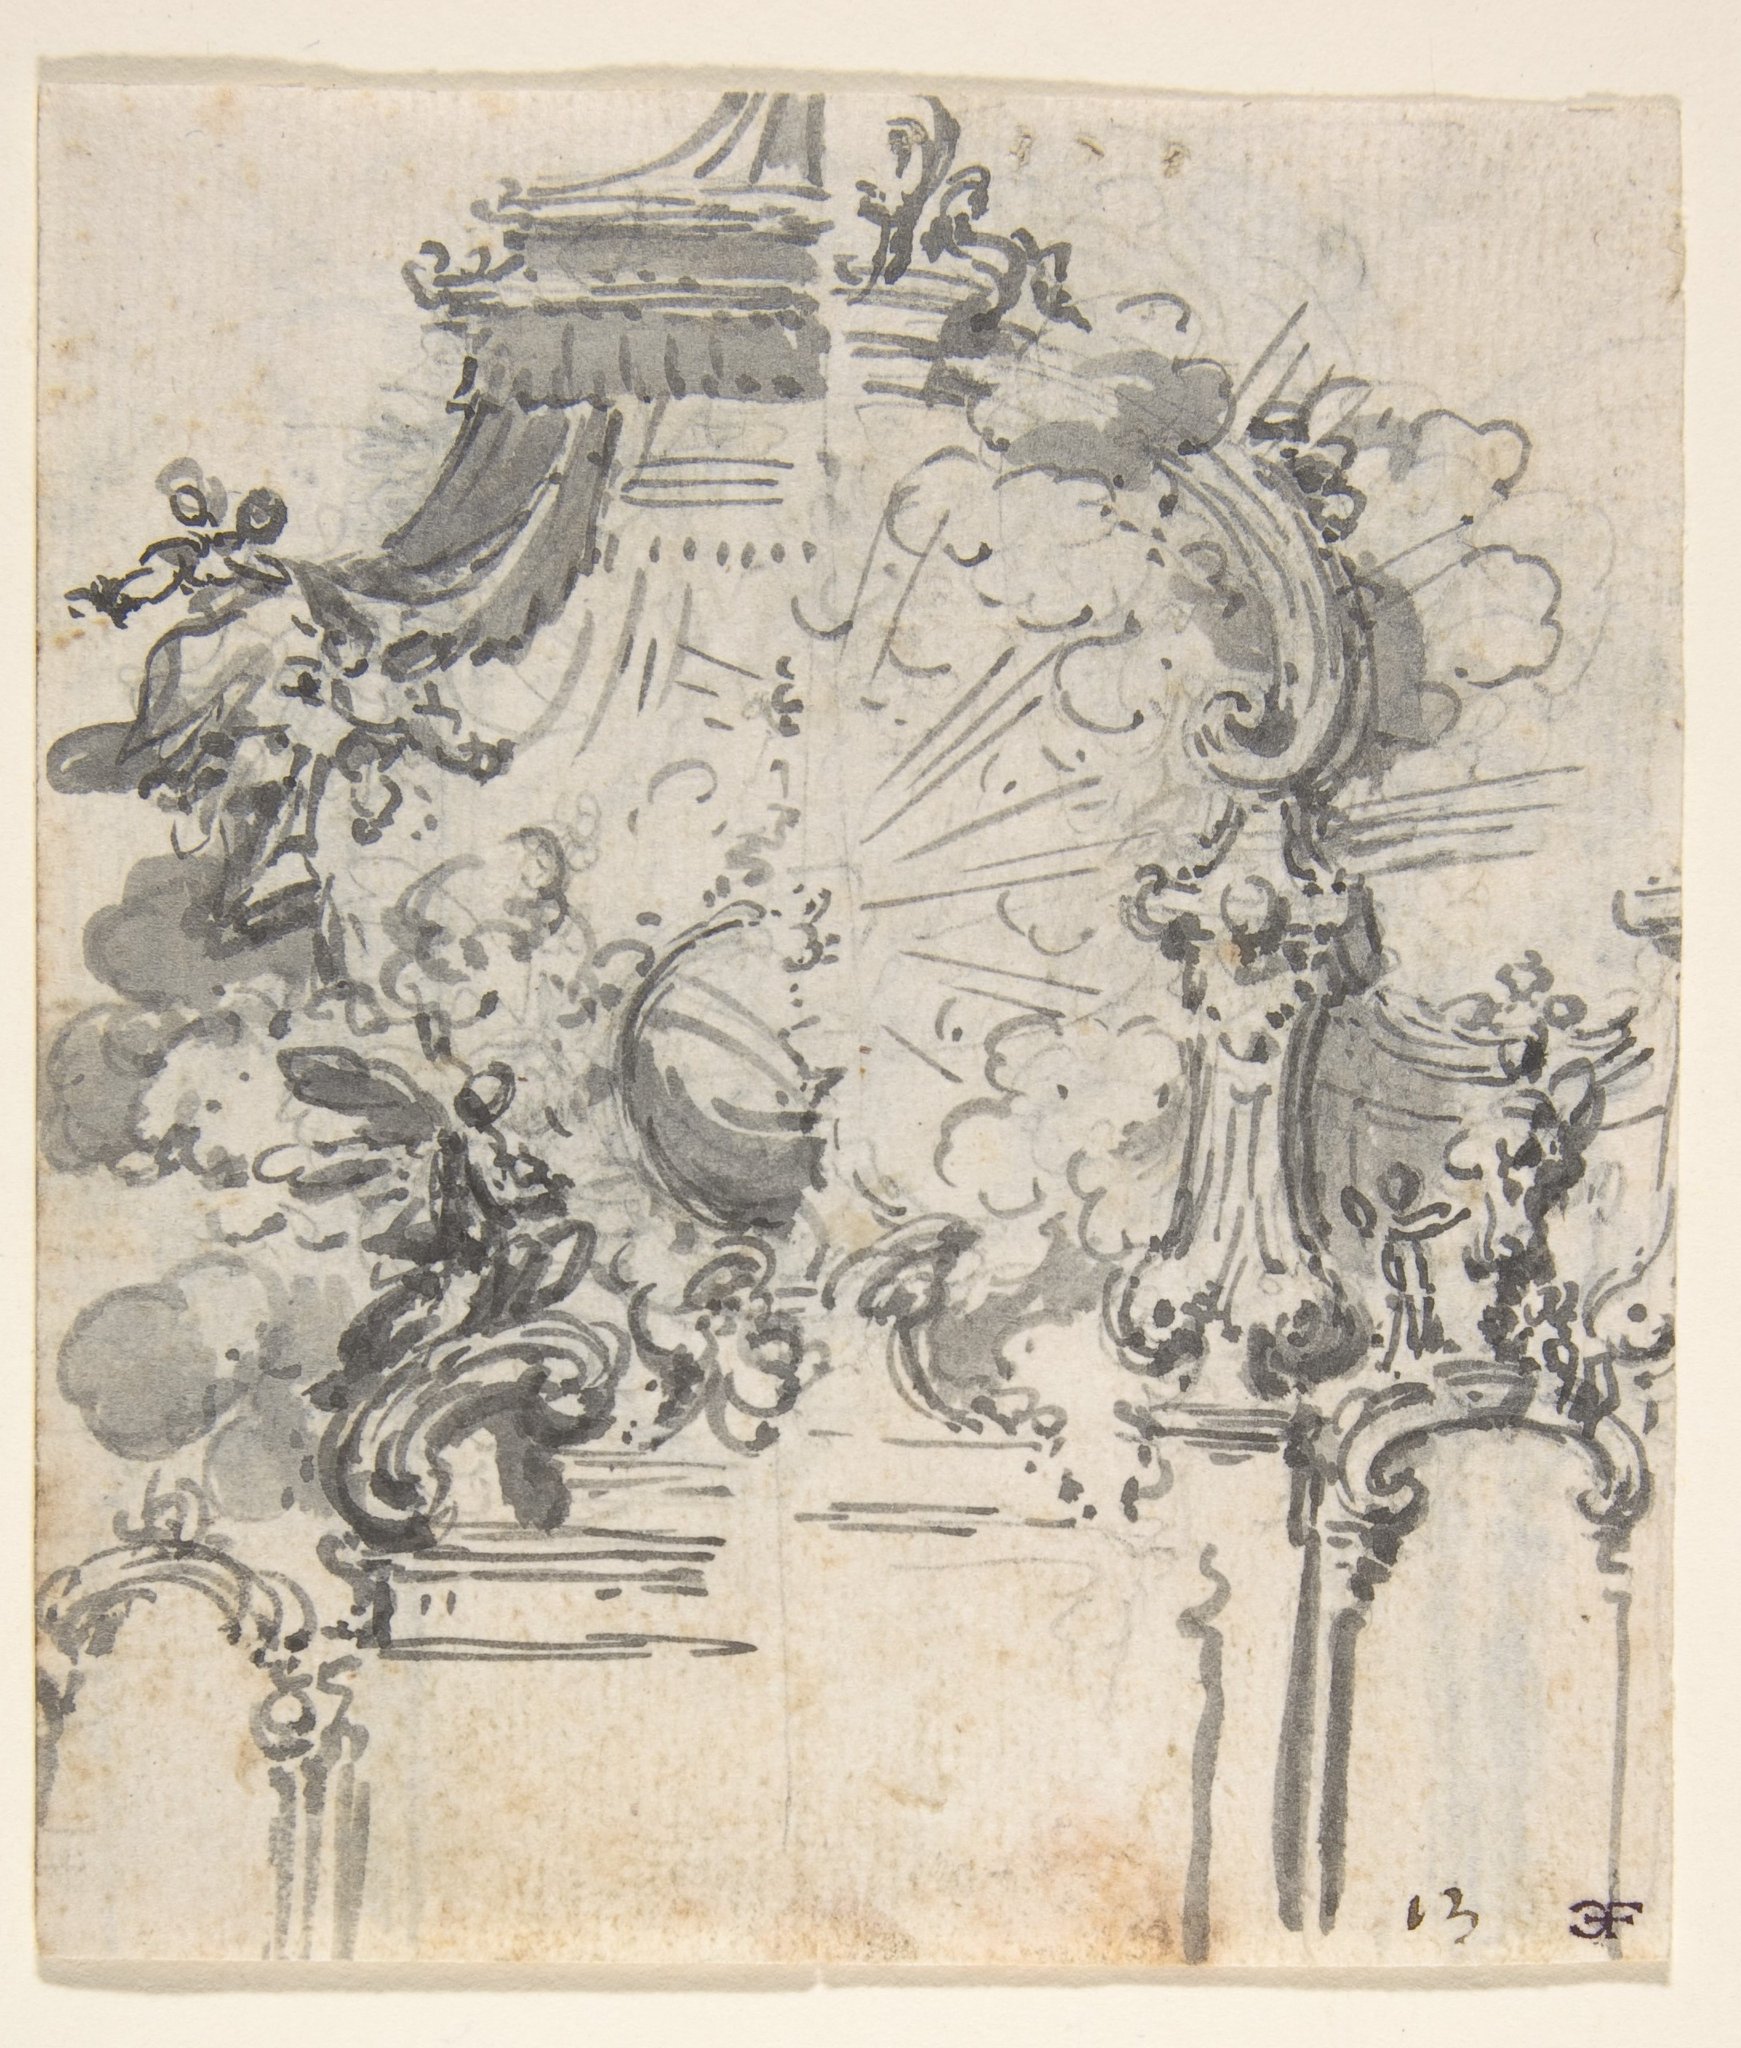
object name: drawing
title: Ornament Design with Alternate Suggestion (recto). Variant Ornament Design with Alternate Suggestion (verso)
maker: giovanni battista natali iii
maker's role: artist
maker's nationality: italian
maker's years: 1698-1765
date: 1698-1765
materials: ink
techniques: brush, wash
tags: ornament